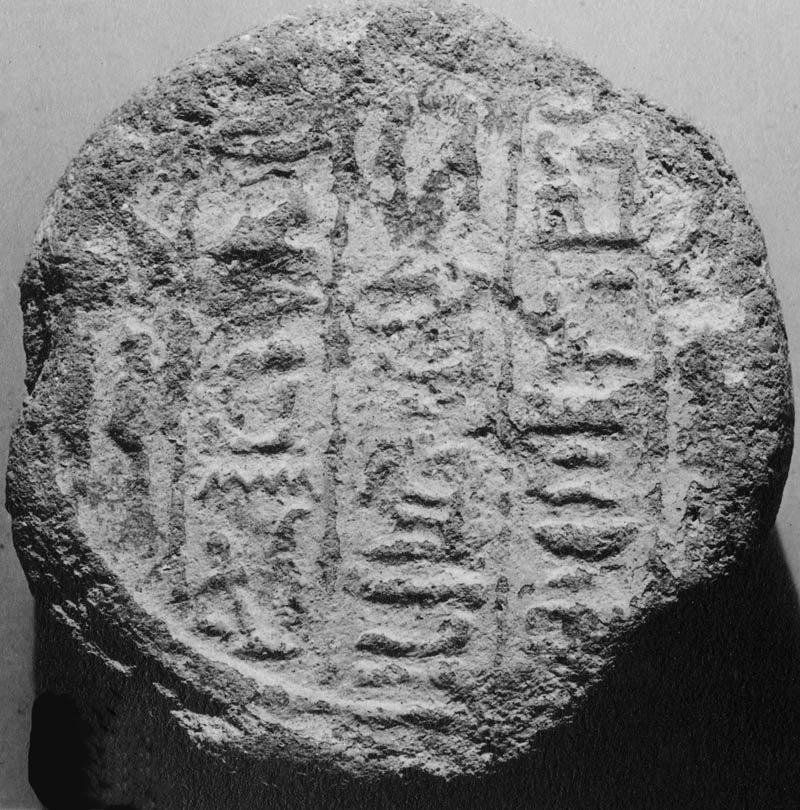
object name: cone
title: Funerary Cone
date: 1550-1295 BCE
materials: pottery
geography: egypt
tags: hieroglyphs